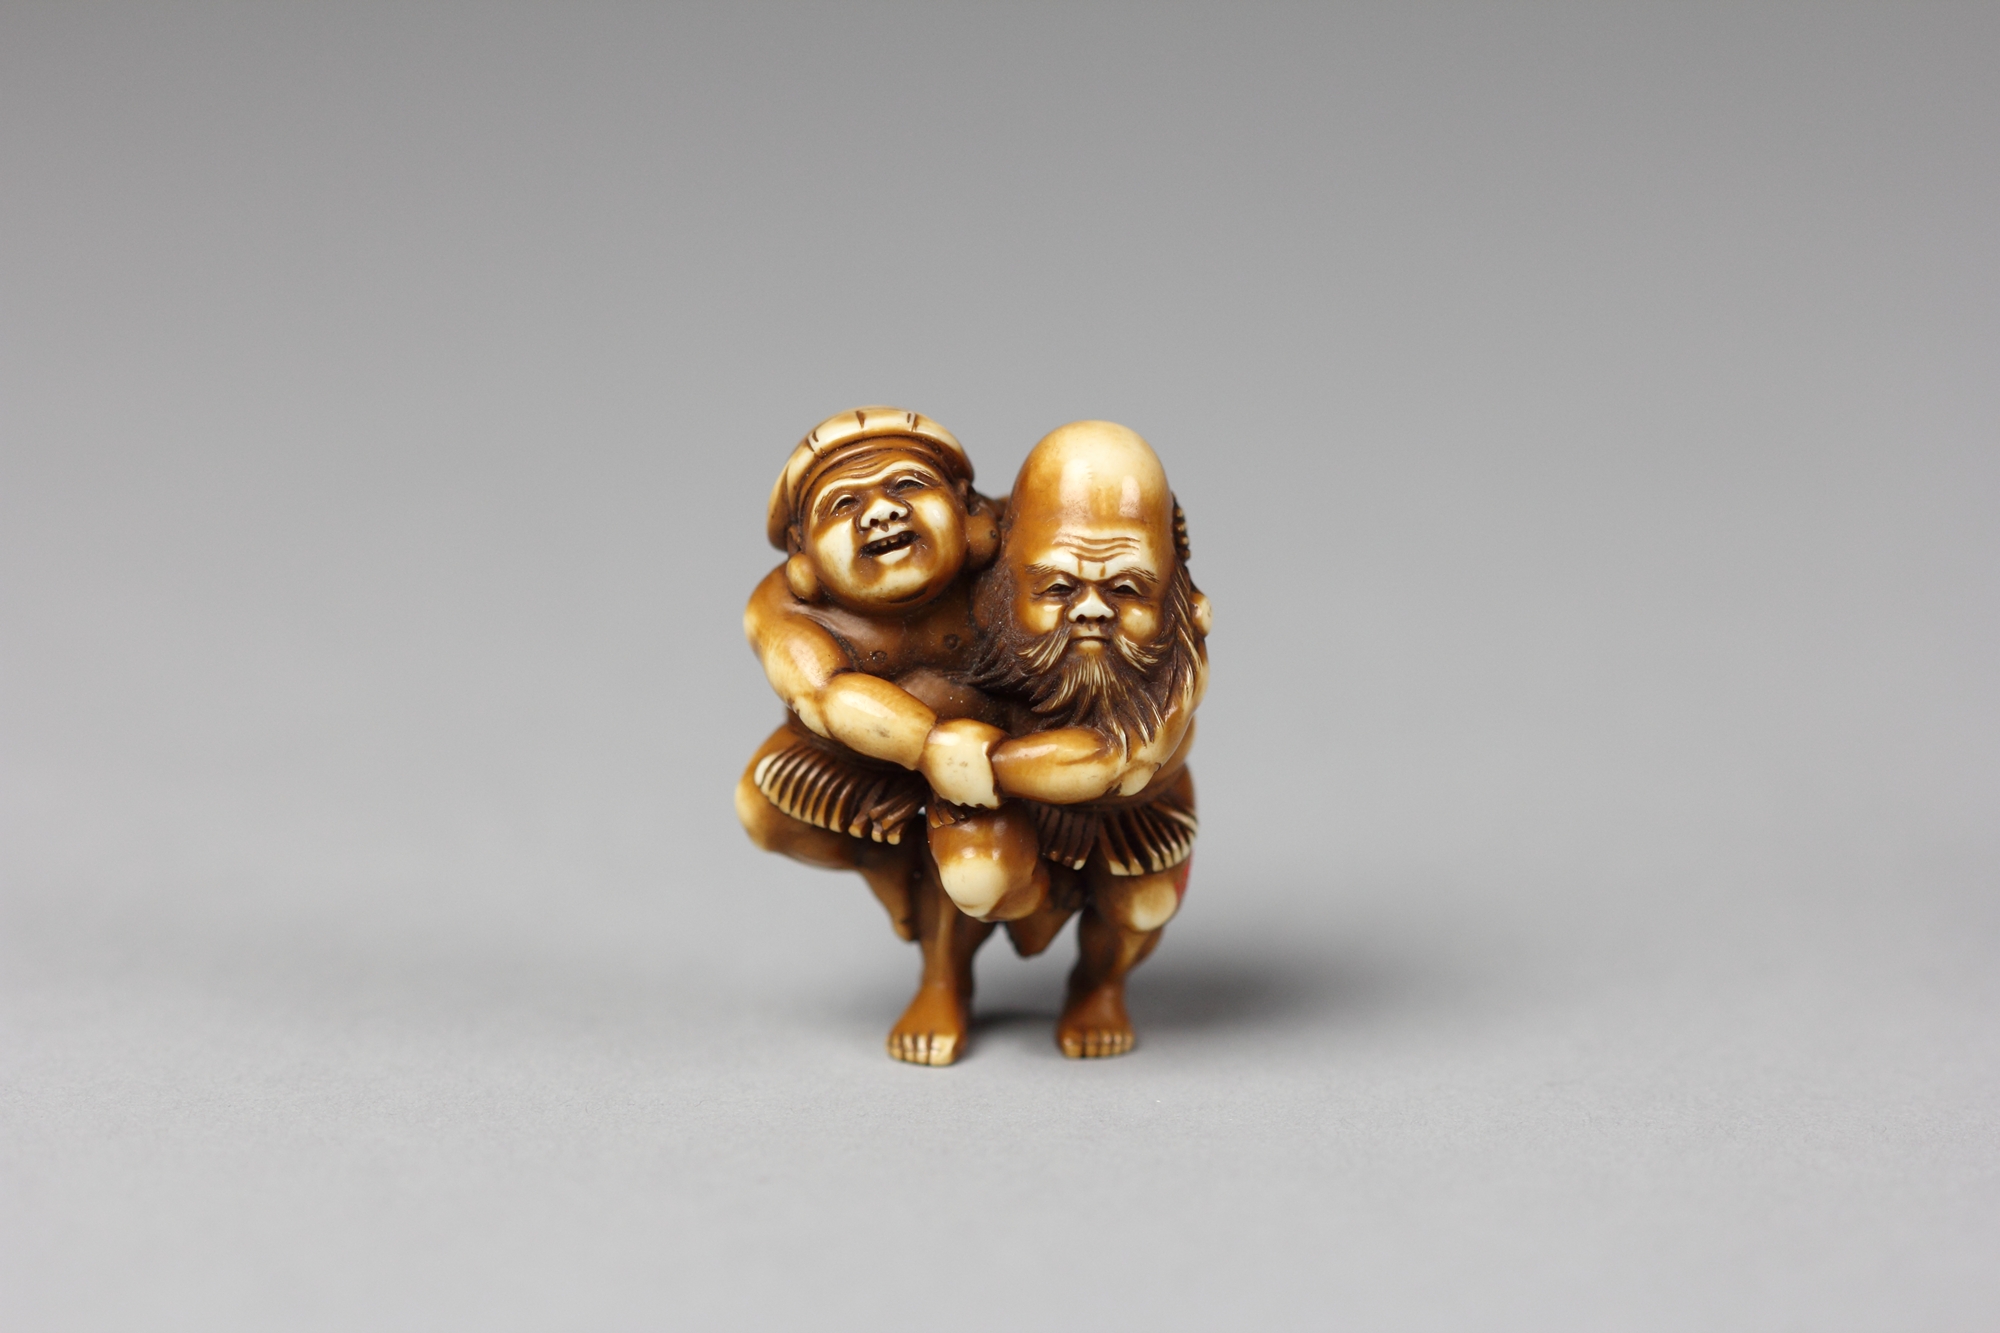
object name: netsuke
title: Netsuke of Daikoku and Fukurokuji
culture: japanese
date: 1801-1900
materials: ivory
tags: men